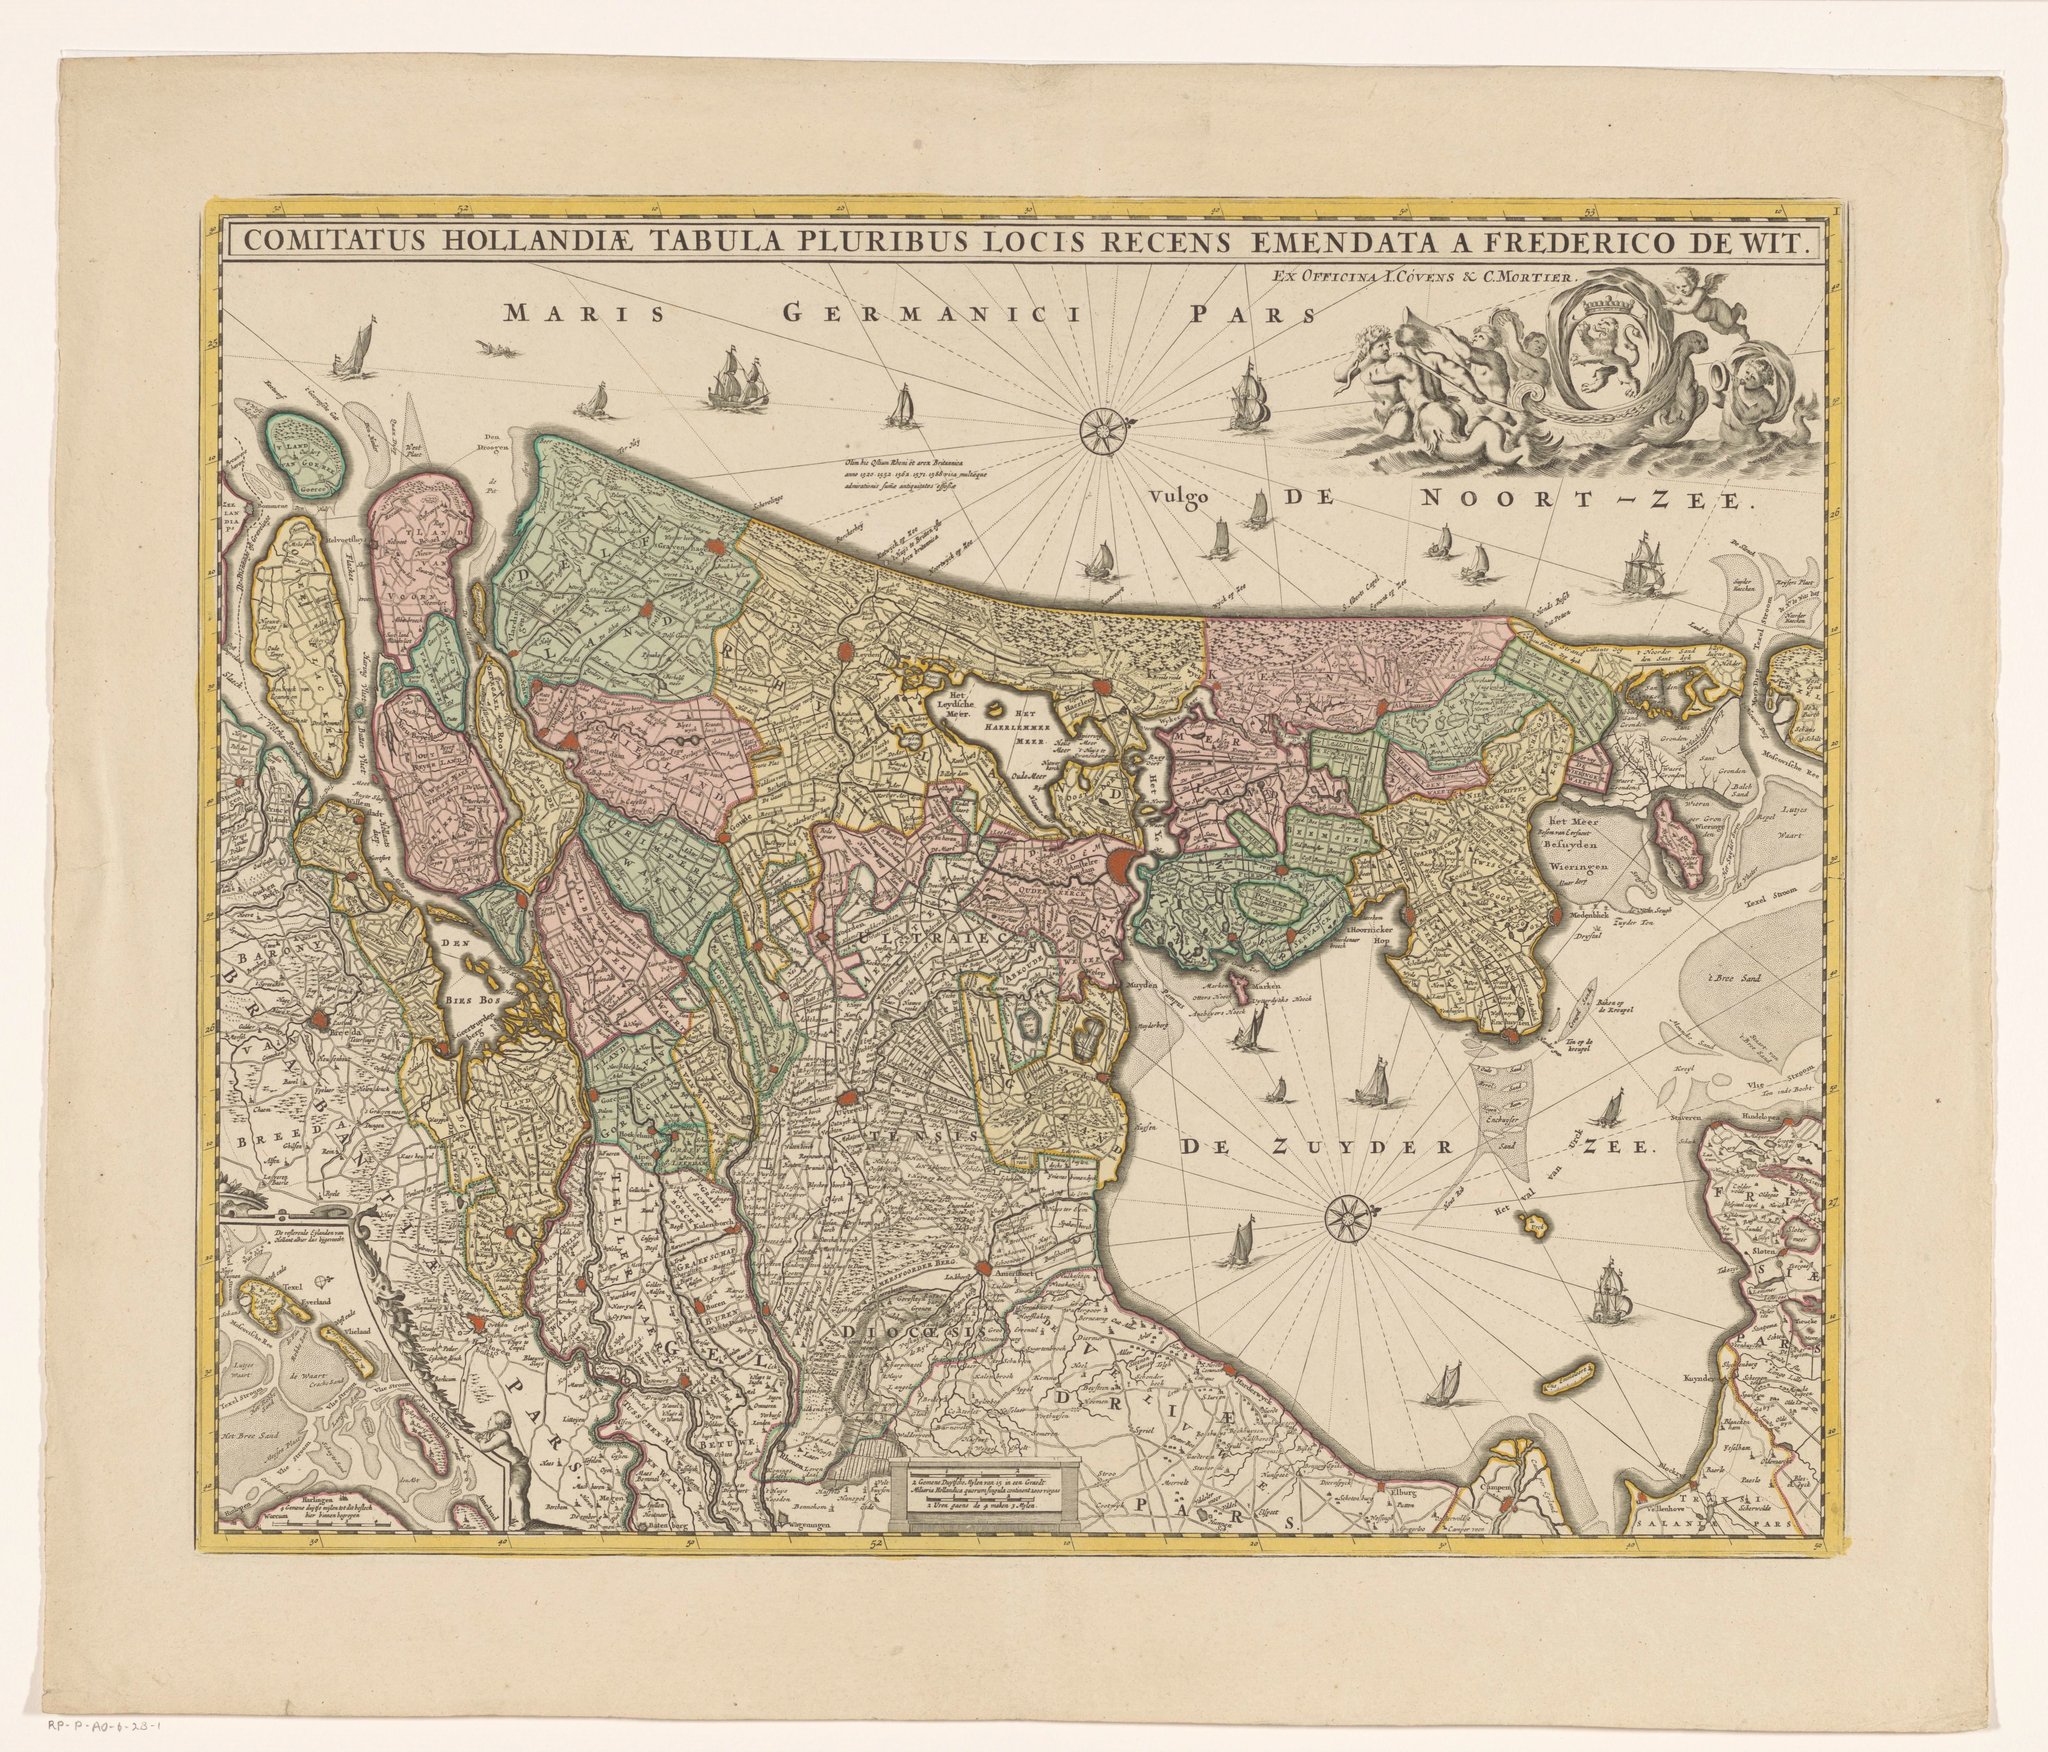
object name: print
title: Comitatus Hollandiae tabula pluribus locis recens …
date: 1721-1774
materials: paper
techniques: engraving, hand coloring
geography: amsterdam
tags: coat of arms (as symbol of the state, etc.), triton(s), maps of separate countries or regions, holland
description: Kaart van het graafschap Holland en omliggende gebieden. Linksonder een inzetkaartje van het Waddengebied met een schaalstok: 4 gemene duijtse tot dit besteck hier binnen begrepen. Onder in het midden twee schaalstokken voor de kaart zelf: 2 gemene Duytsche mylen van 15 in een graedt / Miliaria Hollandica quorum singula continent 2000 virgas; 2 uren gaens de 4 maken 3 mylen. Rechtsboven het wapen van het graafschap met daaromheen putti en tritons. Gradenverdeling langs de randen. Oriëntatie: noorden rechts.